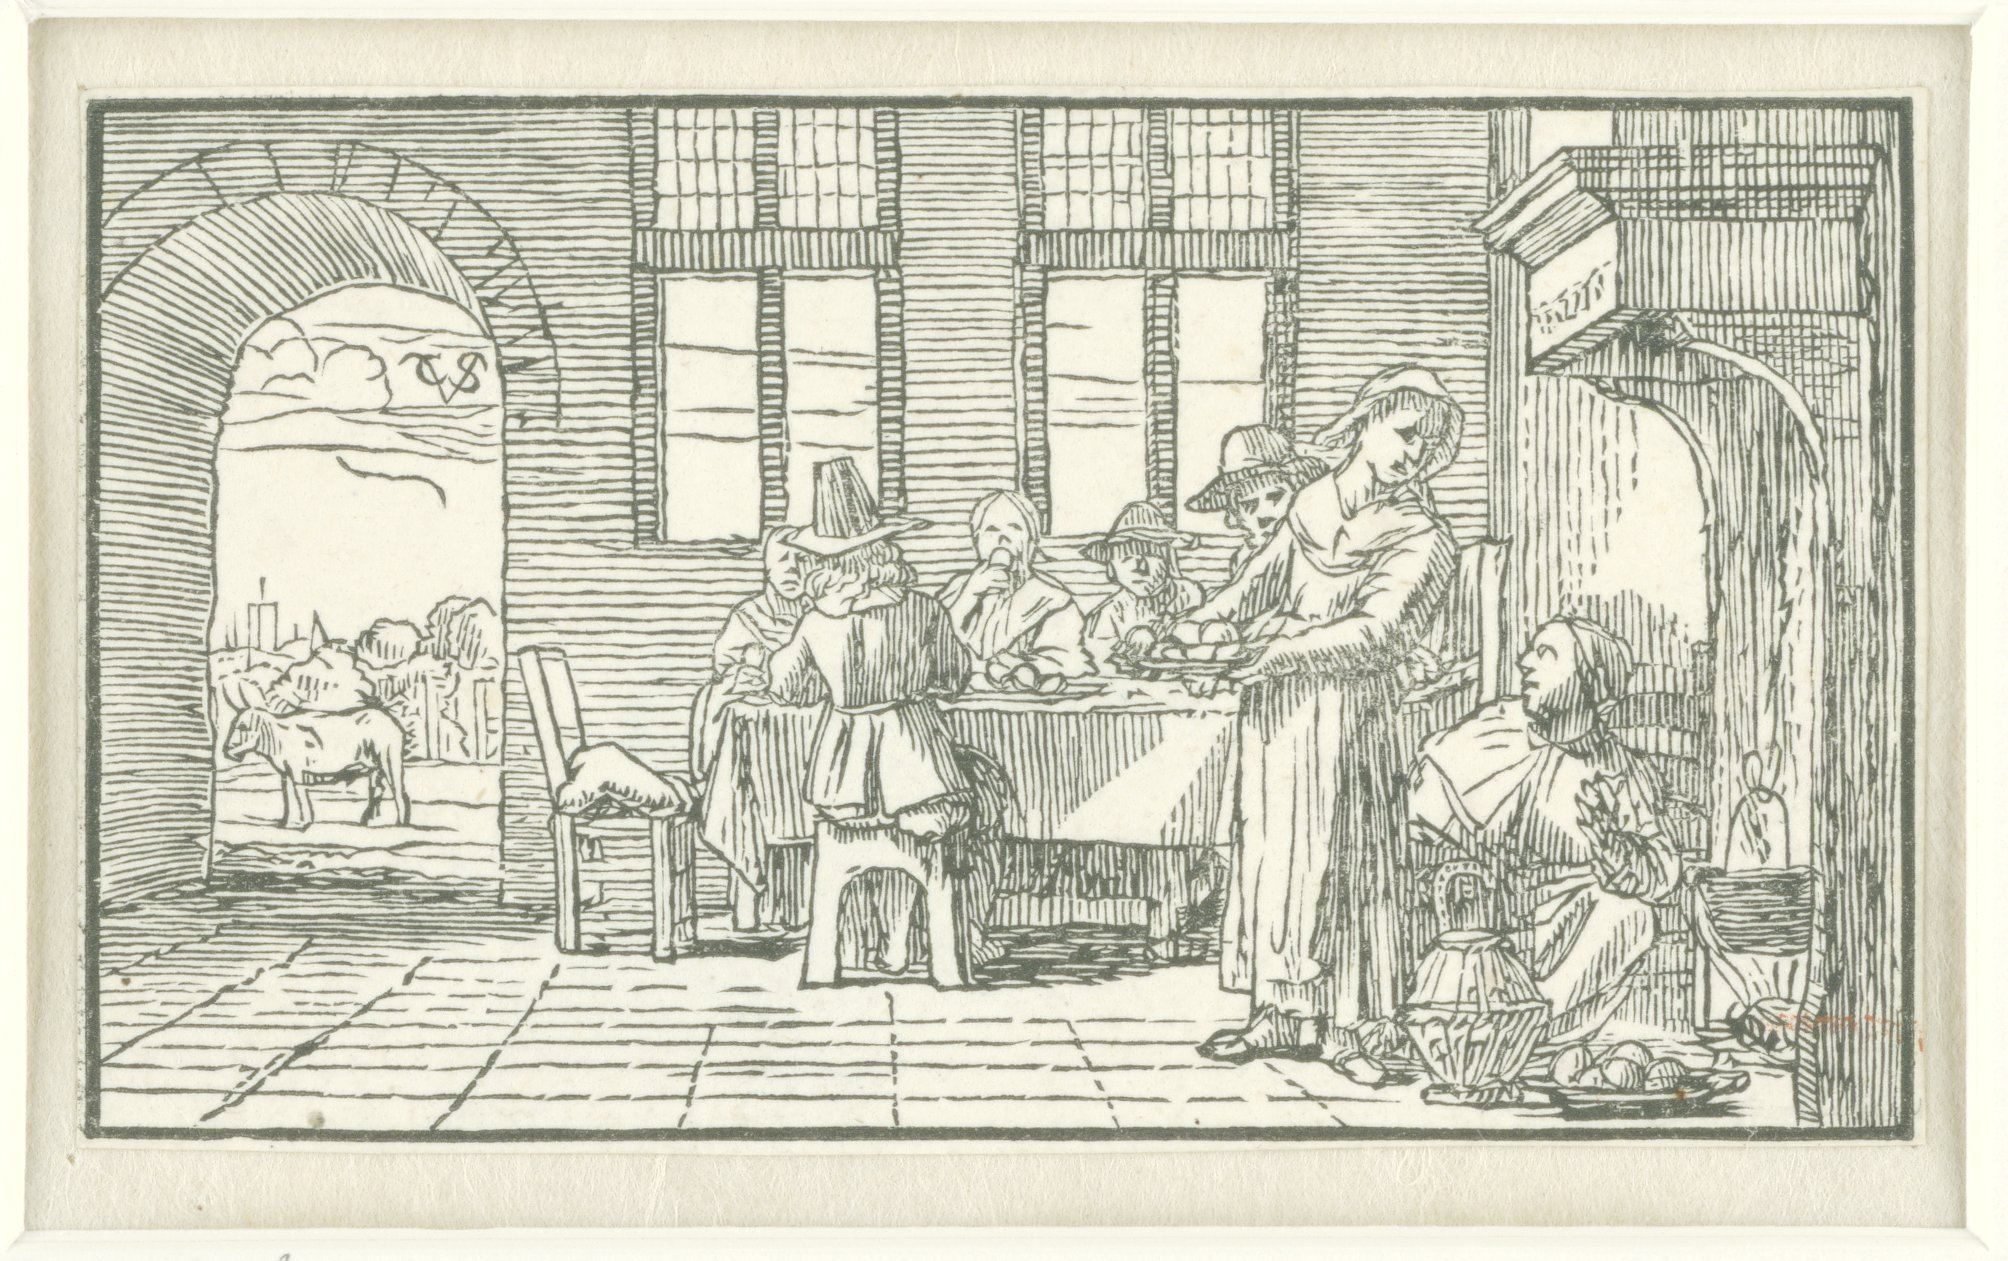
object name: print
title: April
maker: christoffel van sichem (iv)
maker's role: print maker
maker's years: 1642-1698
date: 1652-1718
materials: paper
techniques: woodcut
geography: netherlands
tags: april and its 'labours' (+ with taurus (april))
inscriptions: collector's mark: Lugt 240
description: De viering van Pasen. Vijf figuren zitten aan een tafel eieren te eten. Rechts zit een vrouw op haar knieën stoofpot klaar te maken. Een tweede vrouw heeft een volle schotel voor de gasten in haar handen. Op de achtergrond staat een stier.